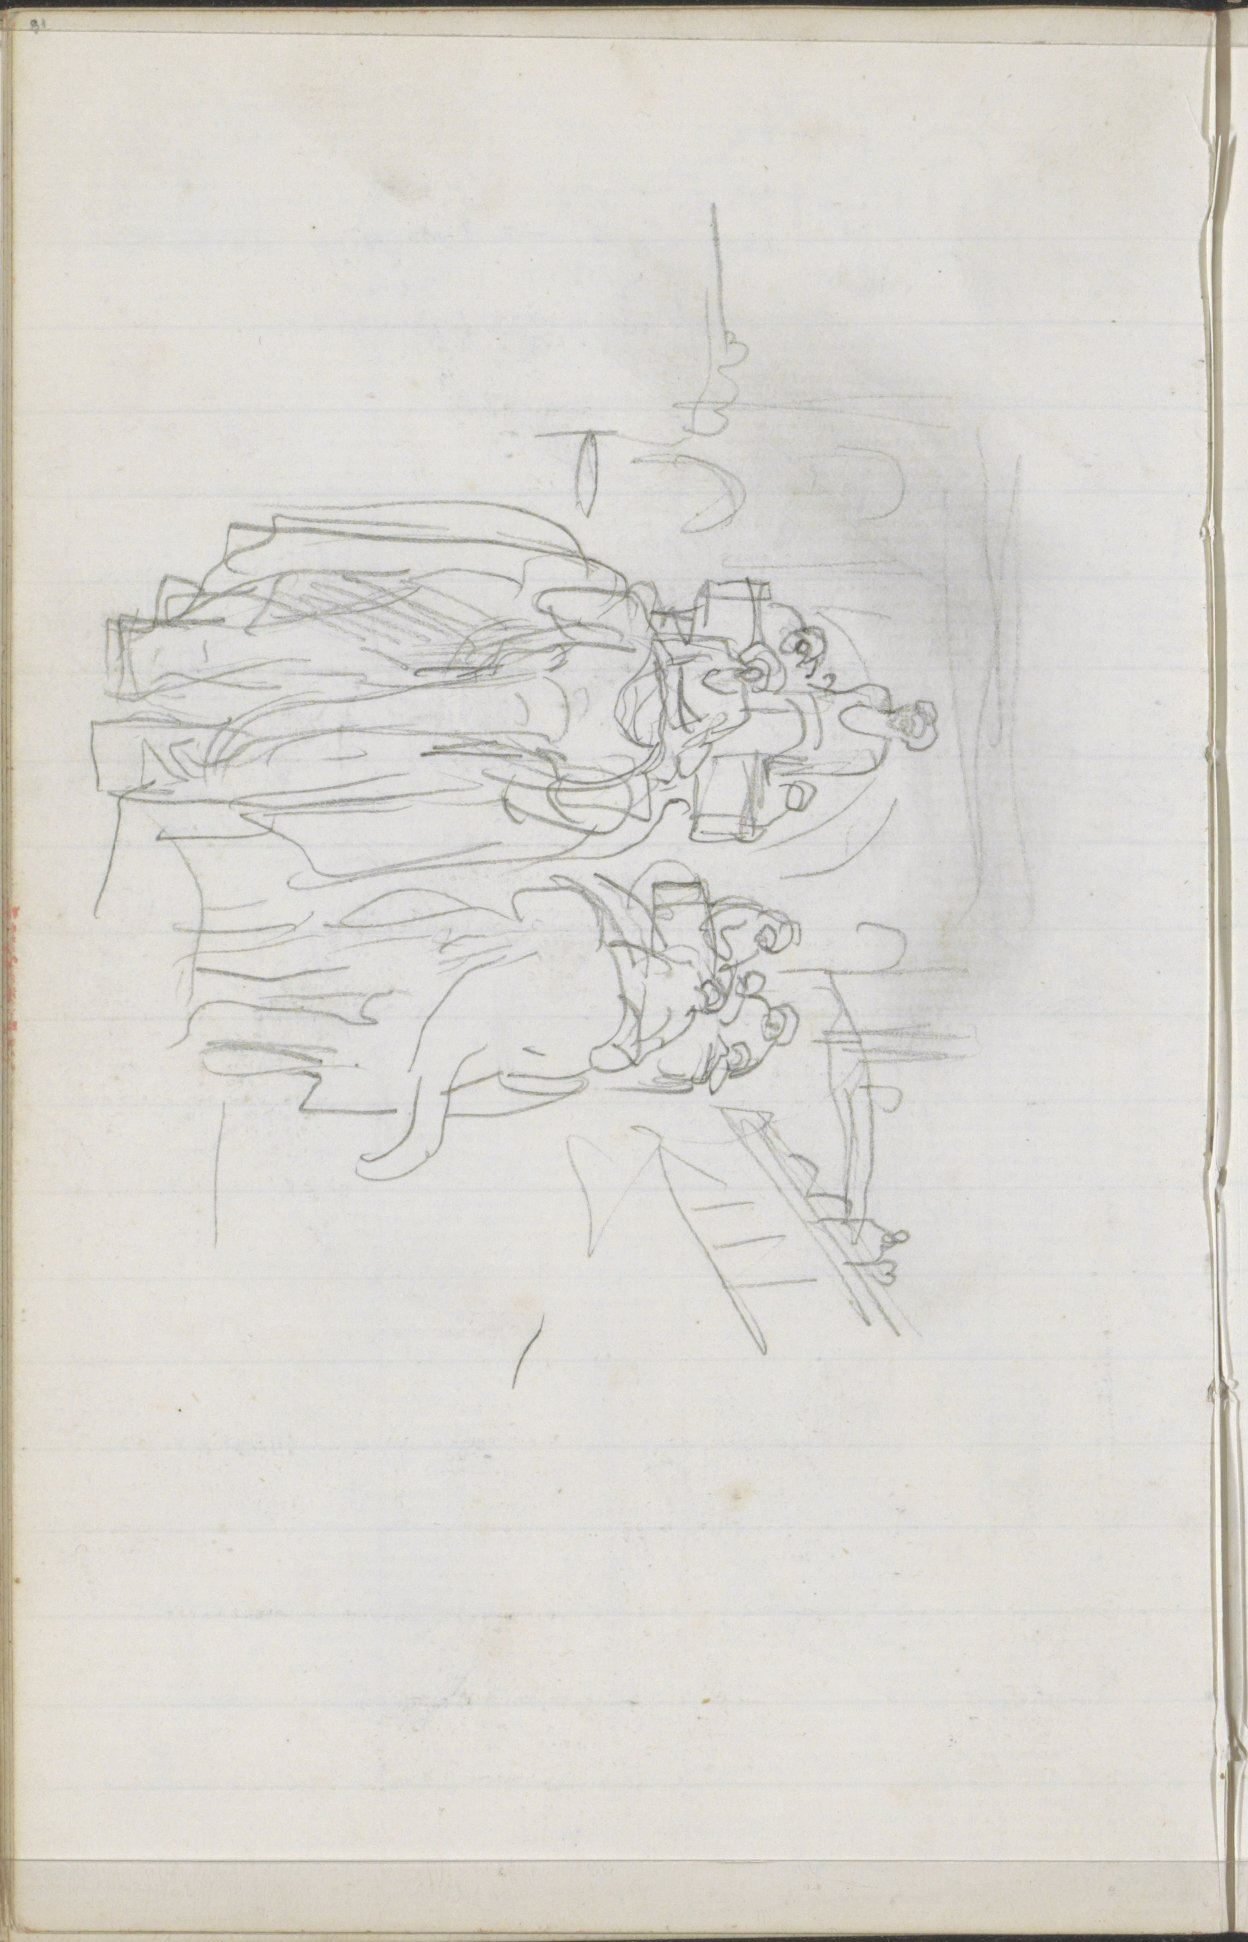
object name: sketchbook leaf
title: Straat met figuren op olifanten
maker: marius bauer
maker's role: draughtsman, print maker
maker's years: 1867-1932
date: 1897-1898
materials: pencil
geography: india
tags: trunked animals: elephant, street (+ city(-scape) with figures, staffage)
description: Pagina 91 uit een schetsboek met 62 bladen.